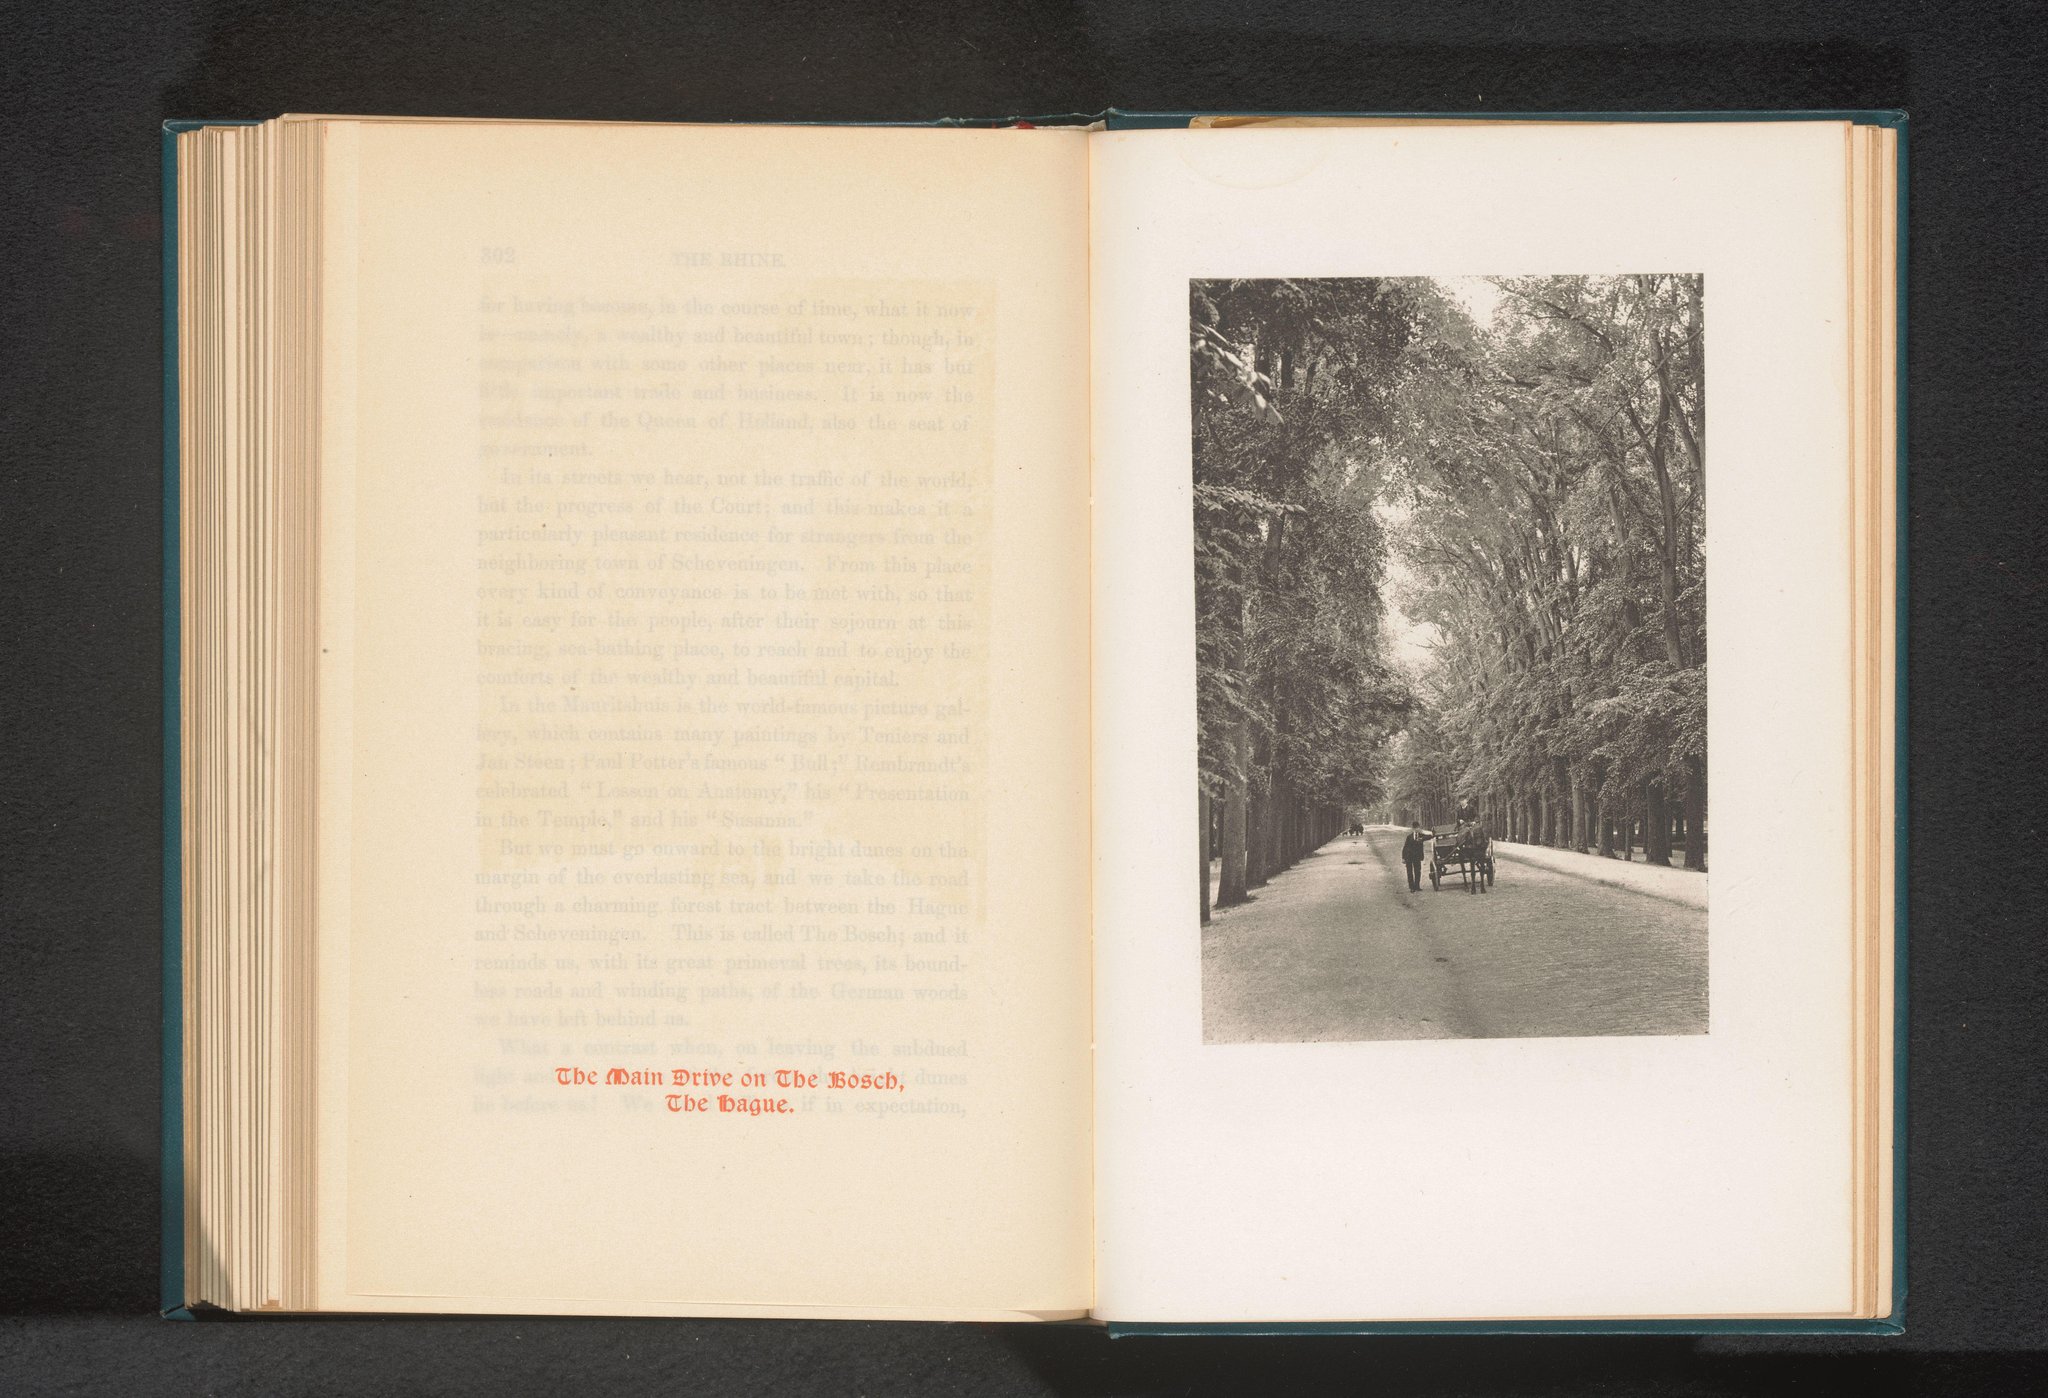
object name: photomechanical print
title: Windmolen te Nederland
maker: Anonymous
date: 1889-1899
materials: paper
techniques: photoaquatint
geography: netherlands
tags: windmill in landscape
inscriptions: title: ‘A Dutch Windmill.’